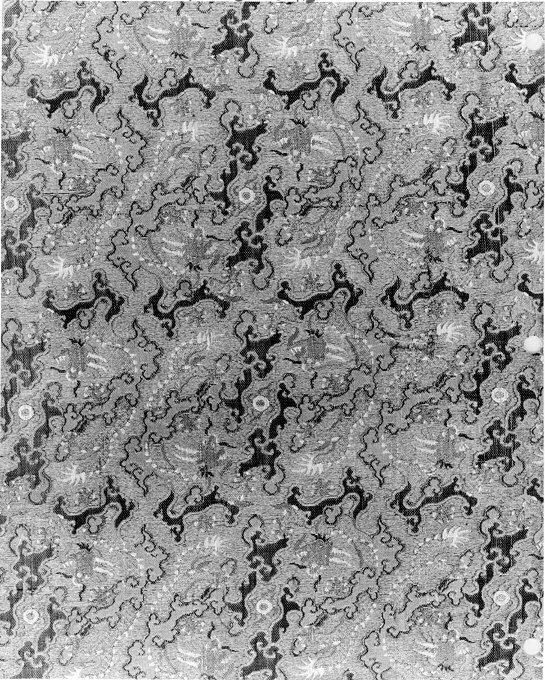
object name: length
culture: chinese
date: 1901-2000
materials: silk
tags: dragons